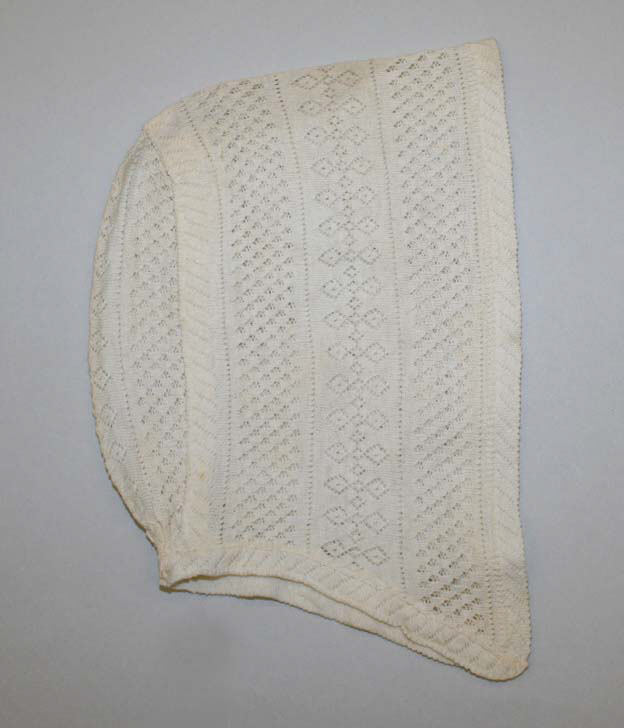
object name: cap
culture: french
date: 1801-1900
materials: wool